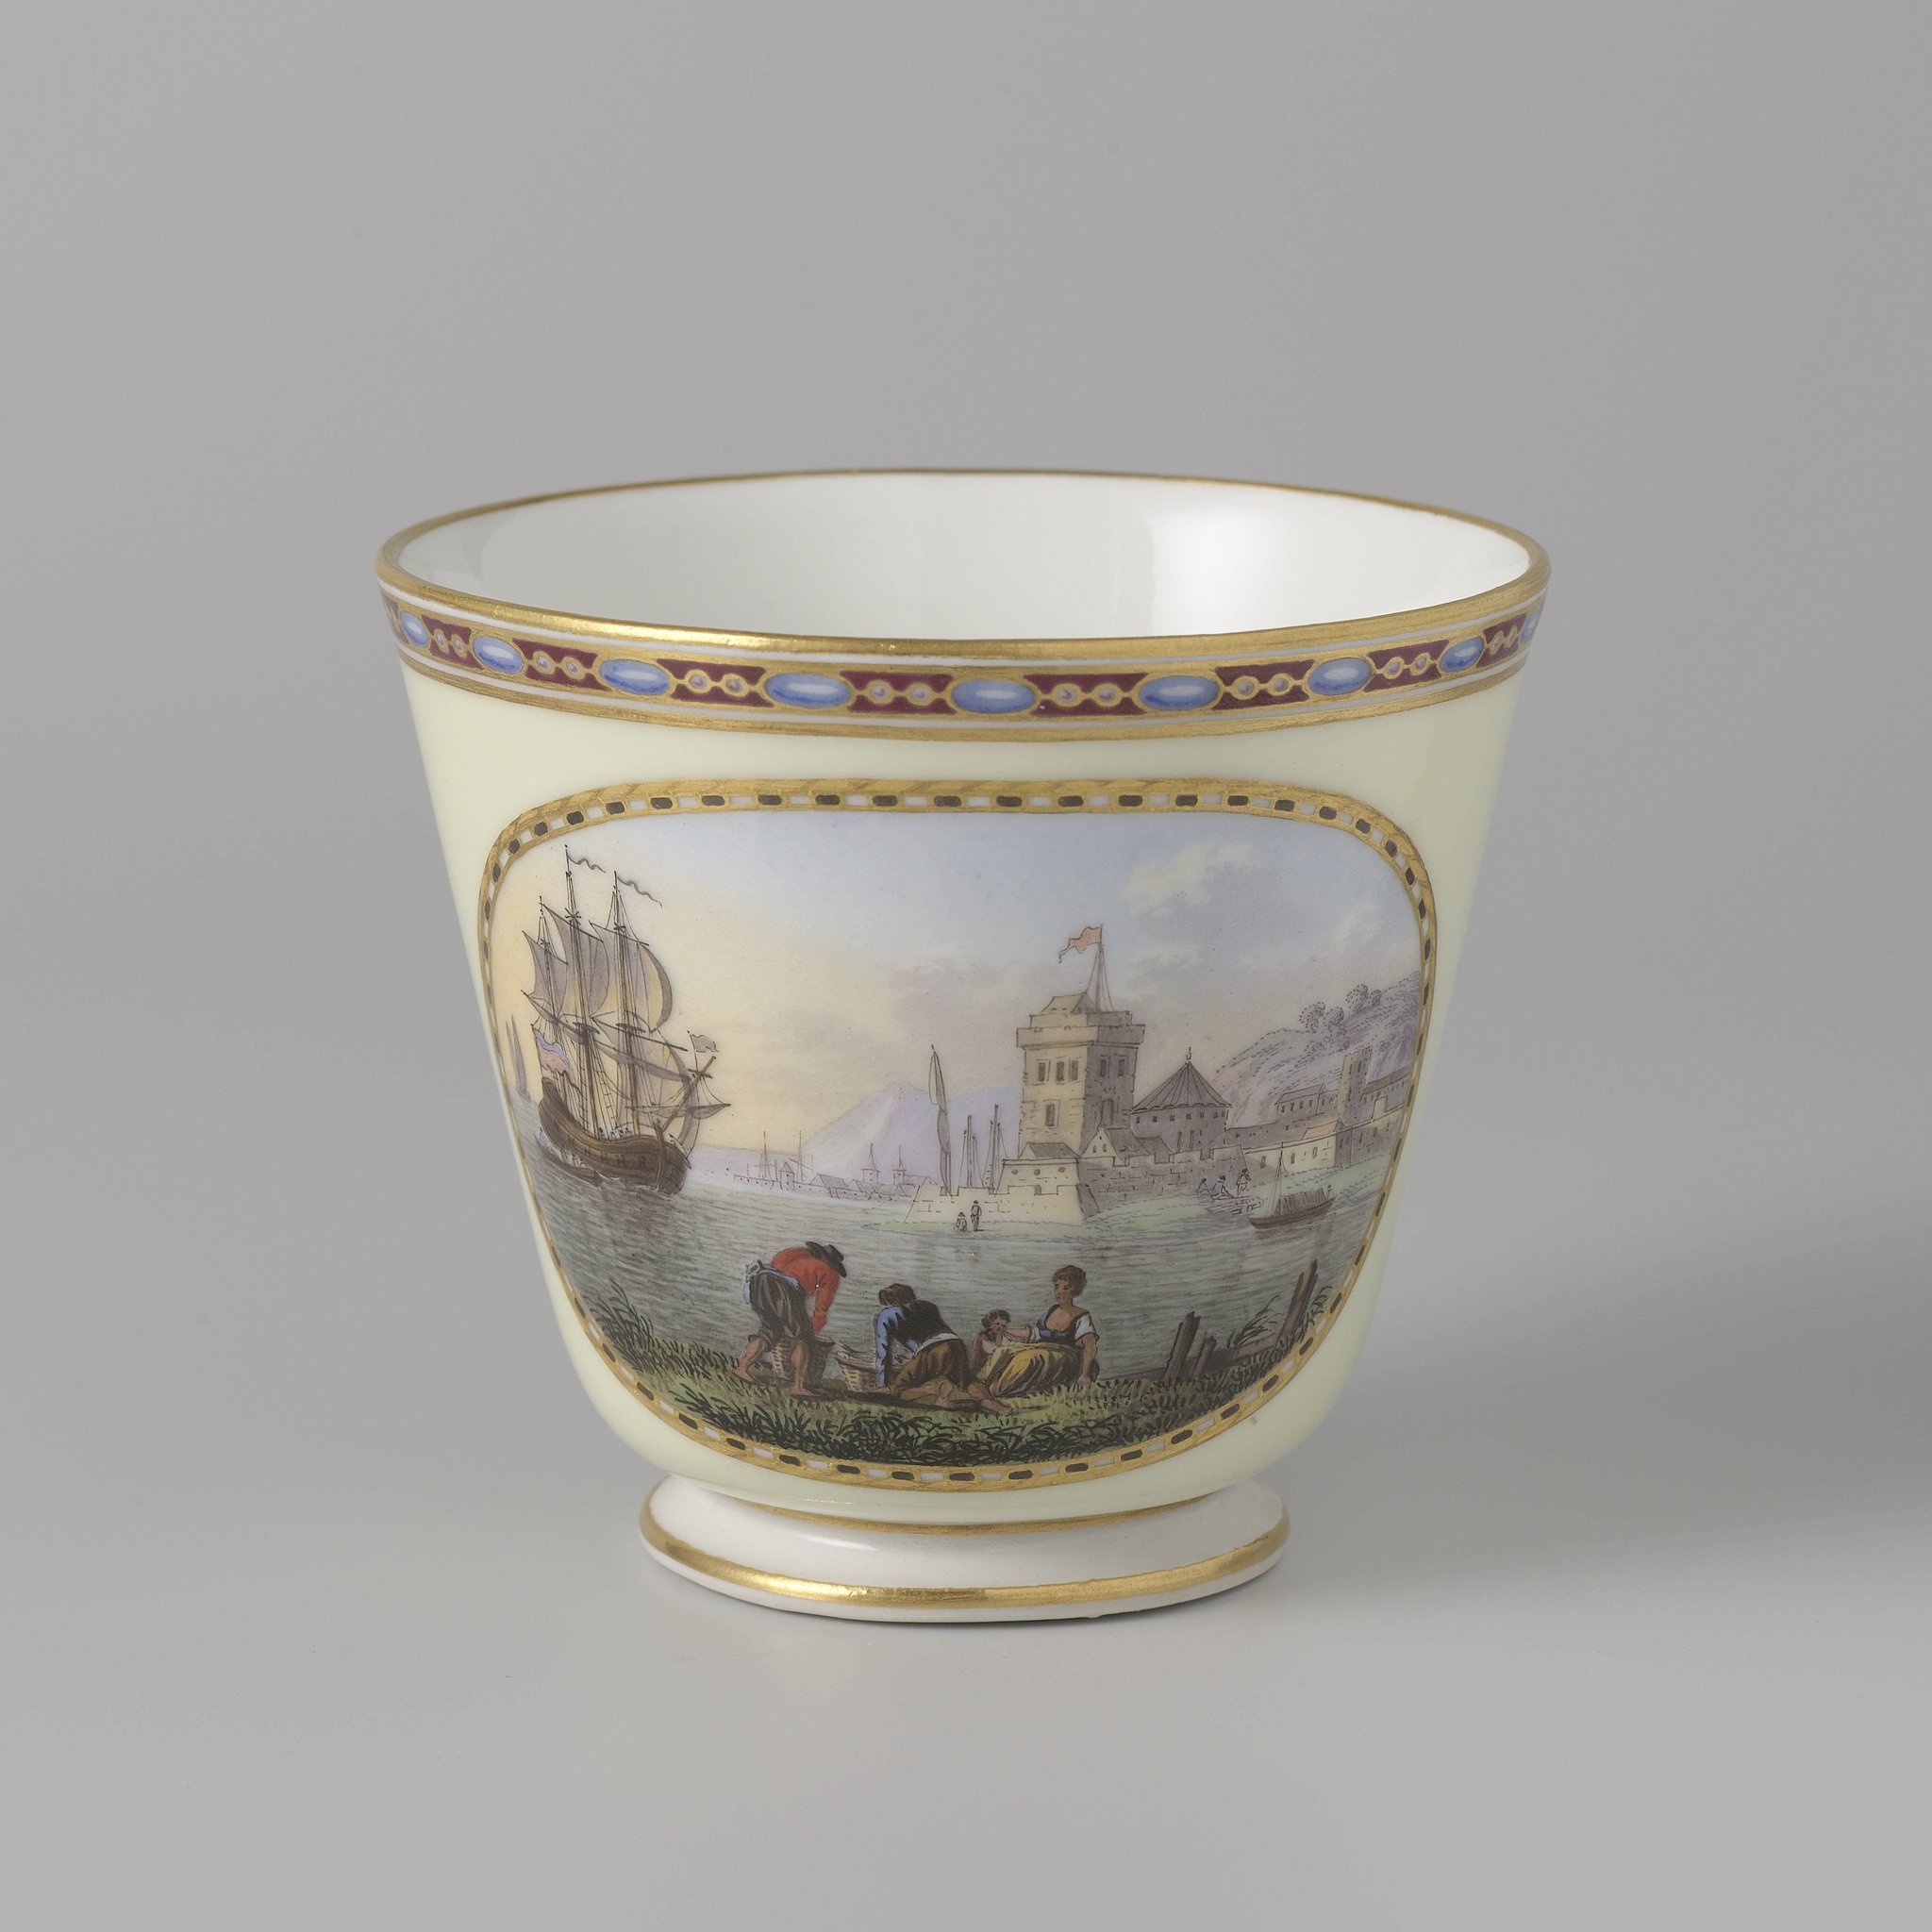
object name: eating drinking utensil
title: Kop, veelkleurig beschilderd met havengezichten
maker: johann gottlob karl liebezeit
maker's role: porseleinschilder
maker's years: 1766-1814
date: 1804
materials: porcelain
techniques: painted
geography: meissen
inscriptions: mark: ‘4’, mold mark, painter's mark: ‘115’, factory mark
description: Déjeuner (small tea or coffee set) with views of Mediterranean ports. On the tray a view ofthe harbour at Marseille. Porcelain. Meissen, dated 1804.